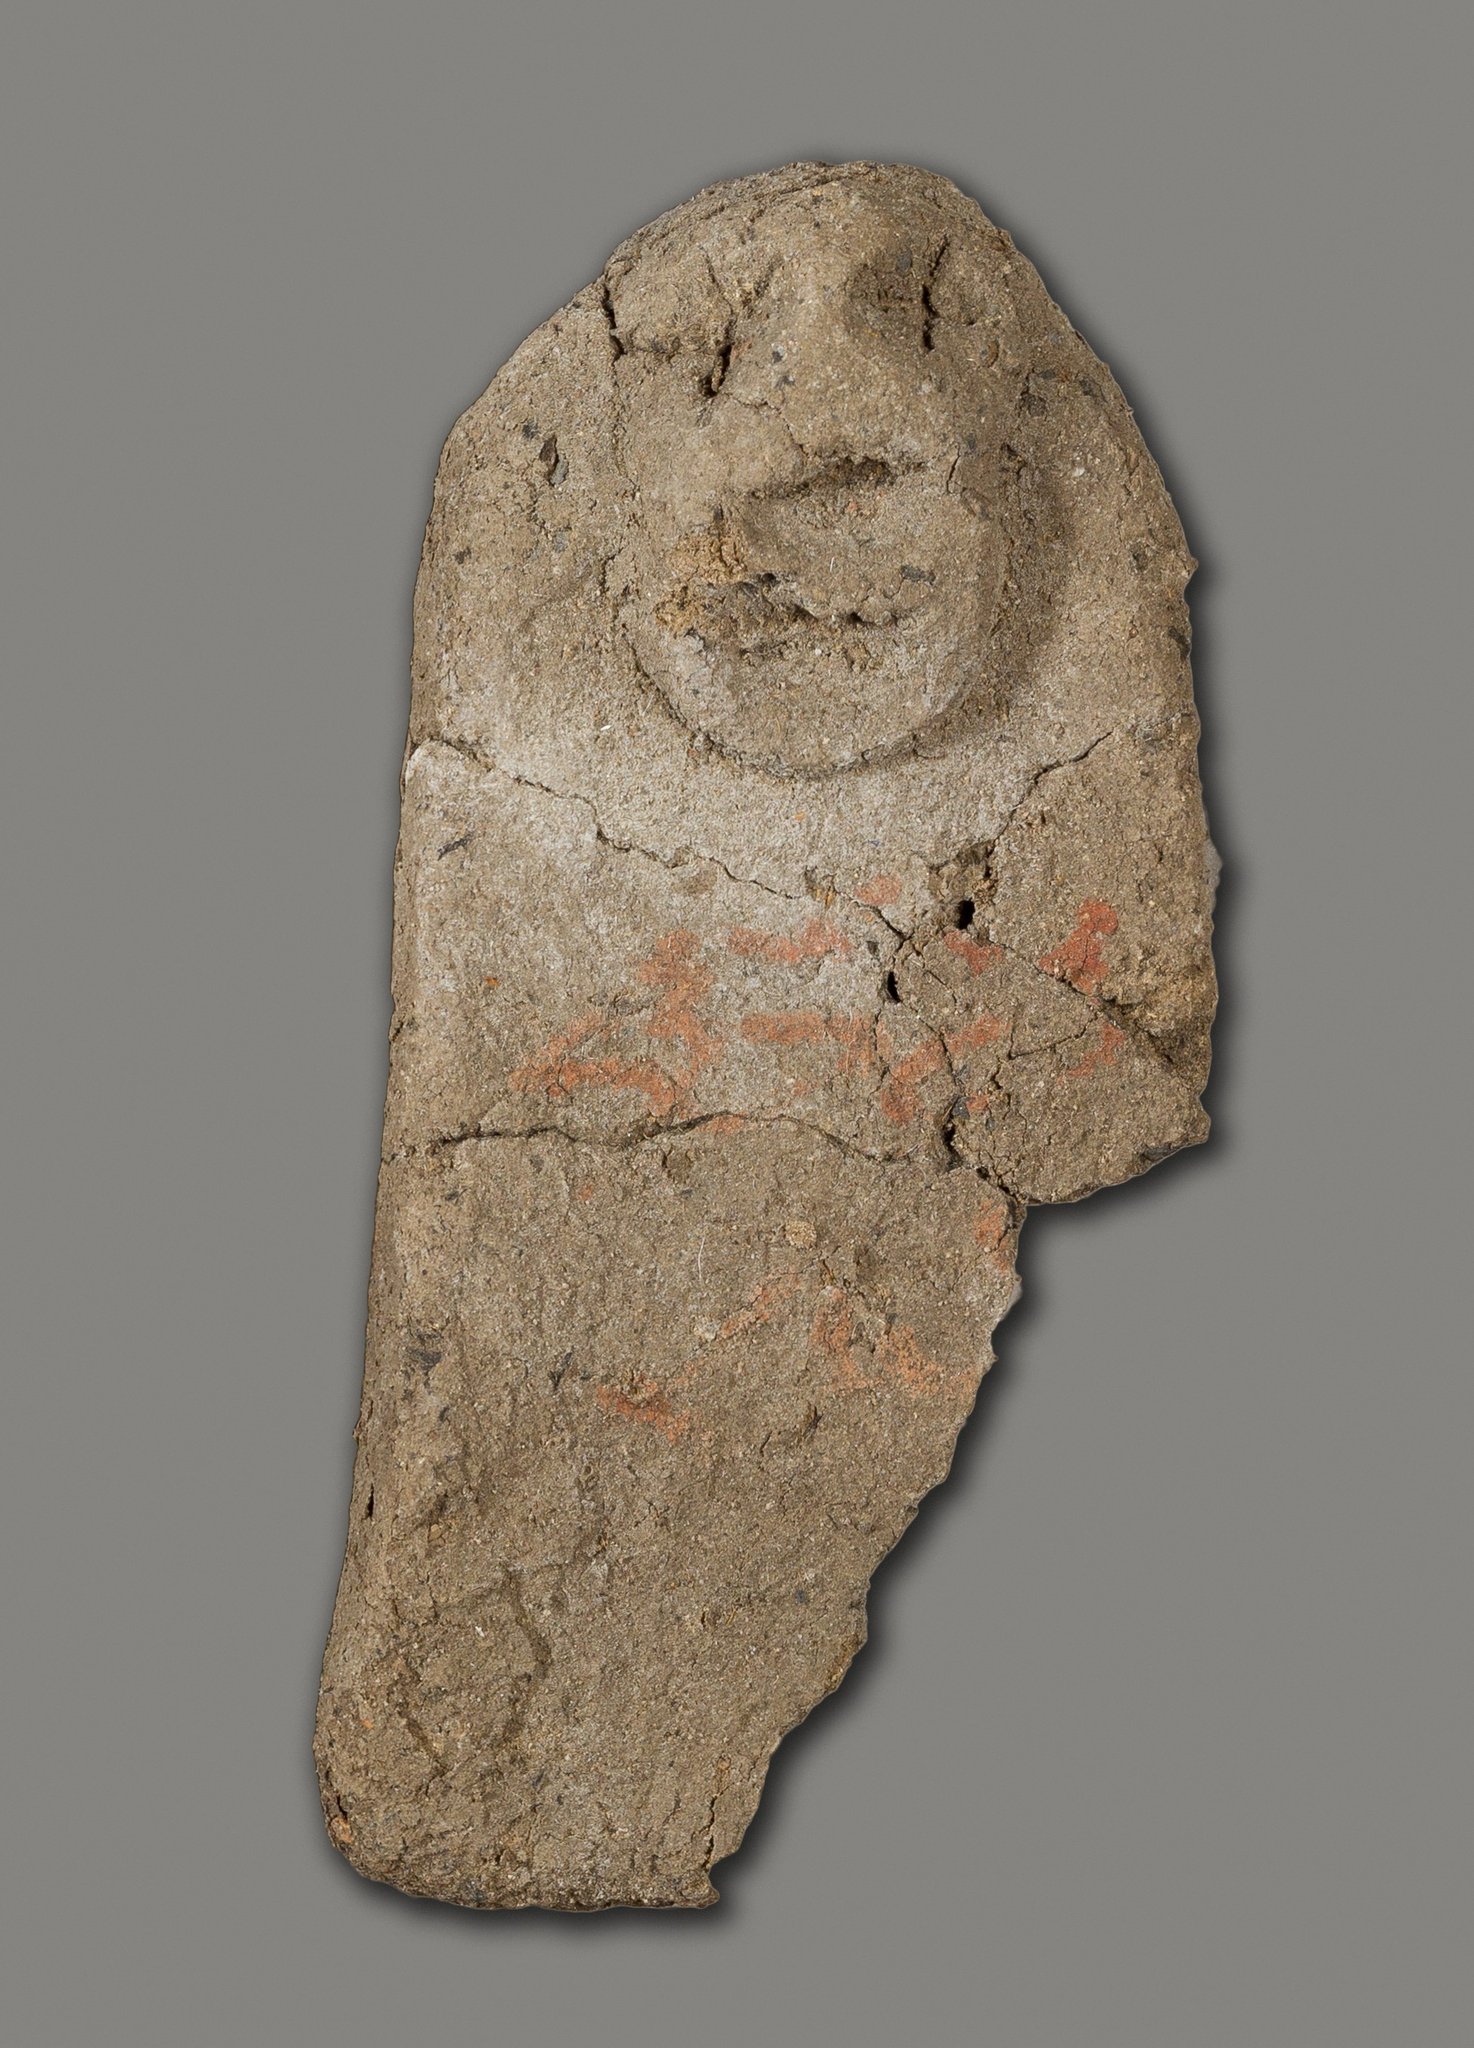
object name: figure, magical, execration, tablet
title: Magical Figure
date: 1802-1550 BCE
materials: clay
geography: egypt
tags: faces